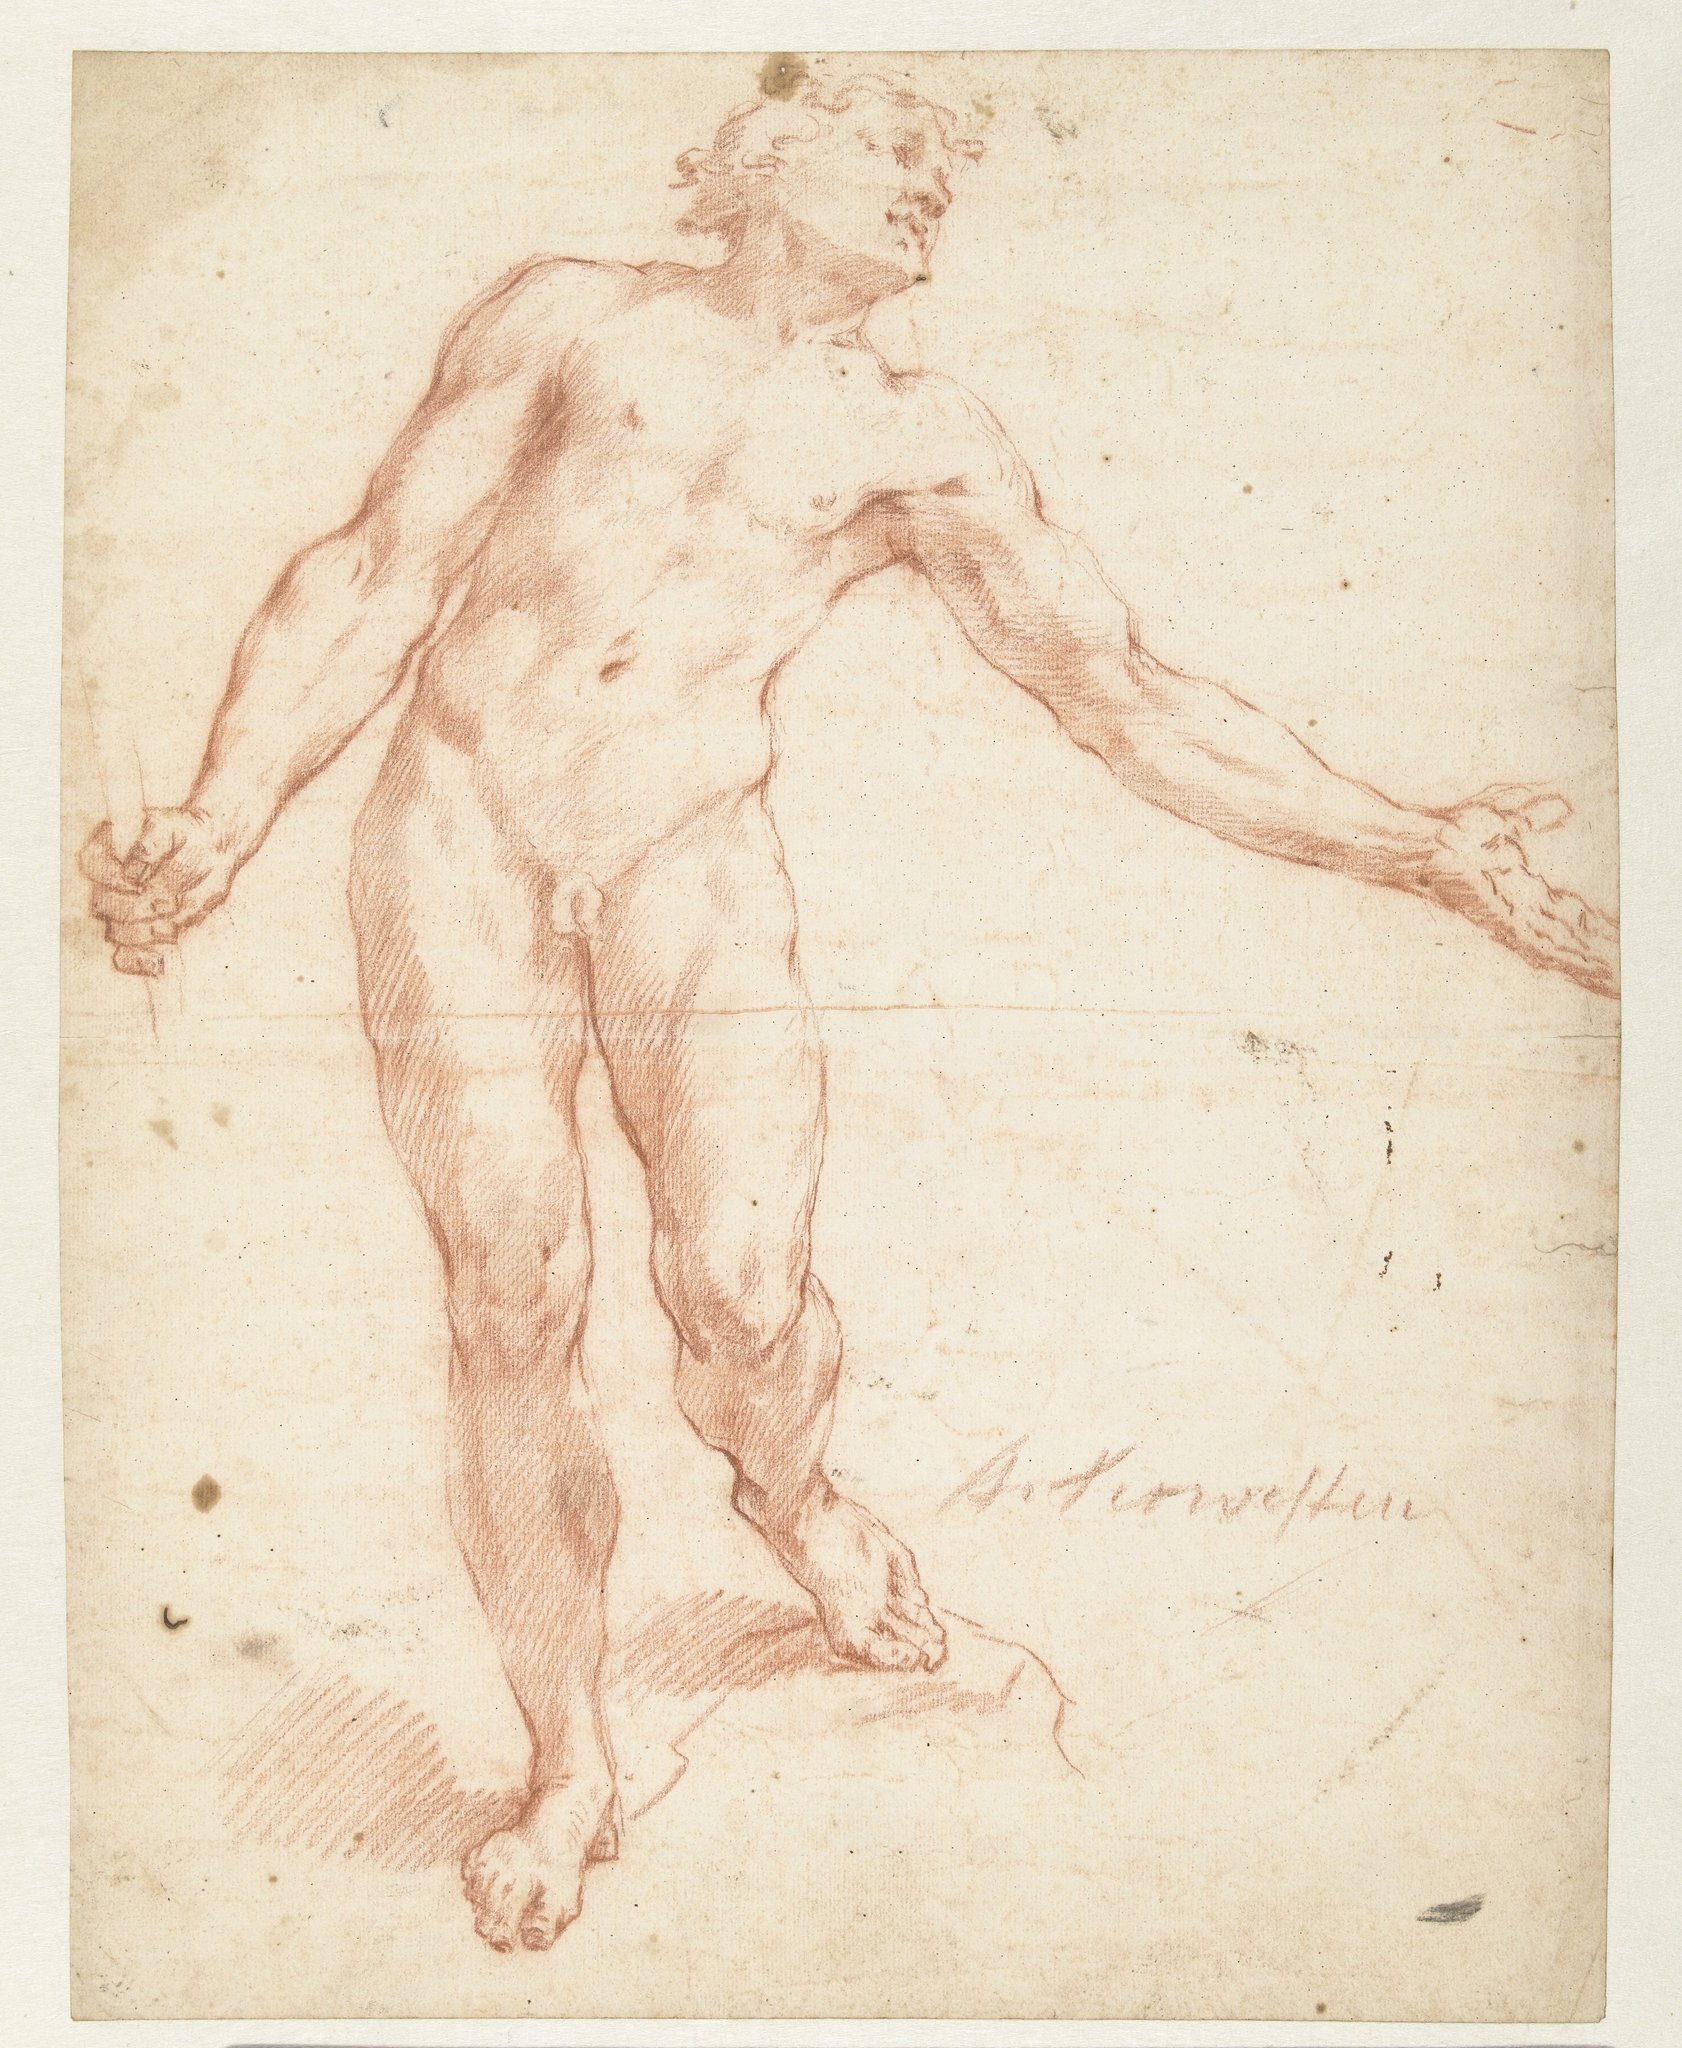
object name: drawing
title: Staand mannelijk naakt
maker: augustinus terwesten (i)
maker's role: draughtsman, painter, print maker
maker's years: 1649-1711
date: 1659-1711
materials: chalk, paper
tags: standing figure